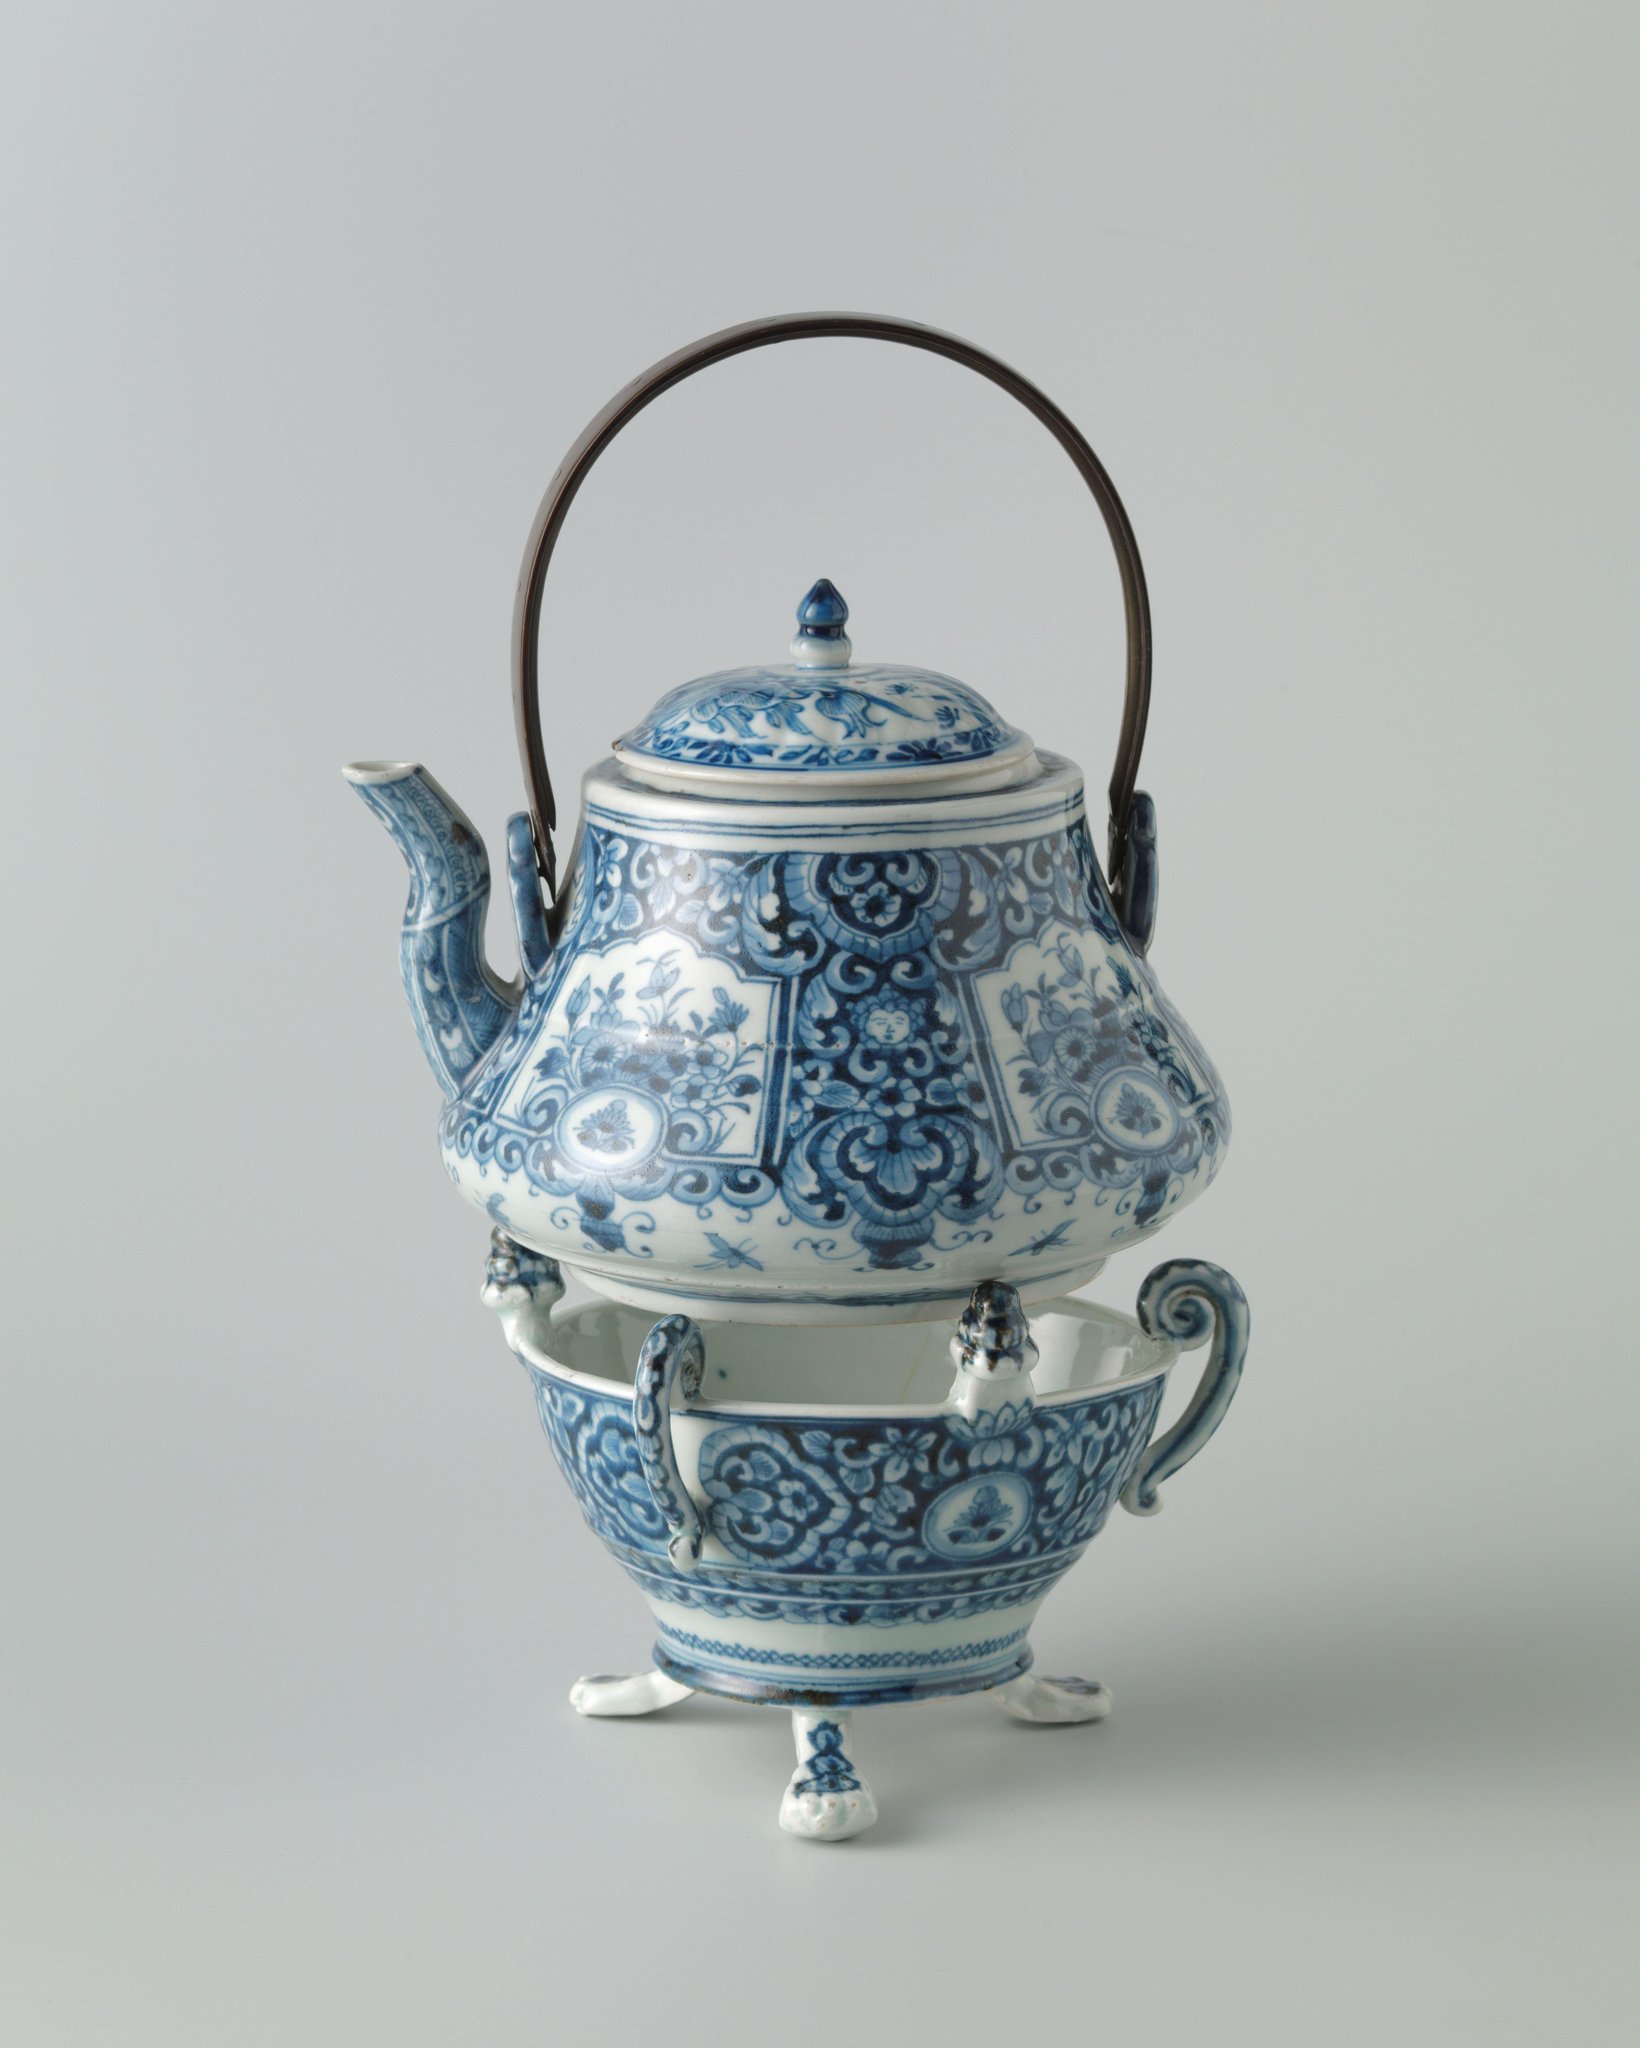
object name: kettle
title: Kettle on stand with flowering plants and foliate scrolls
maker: Anonymous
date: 1750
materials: baleen, cobalt, glaze, paint, porcelain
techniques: firing, turning, vitrification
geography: japan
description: Gedrukt balustervormige ketel met een S-vormige tuit en twee ogen waaraan een hengsel van walvisbeen is bevetigd. een vrij vlakke, klokvormige deksel met een puntige dekselknop. Het komfoor staat op drie voeten en heeft aan de boben zijde drie gemodelleerde knoppen en drie S-voluten waarop de ketel rust. Beschilderd in onderglazuur blauw met op de ketel vier velden met bloeiende planten, omgeven door een druk (Europees) patroon van ranken, lambrequins en engelenkopjes. Dit zelfde decor siert het komfoor.